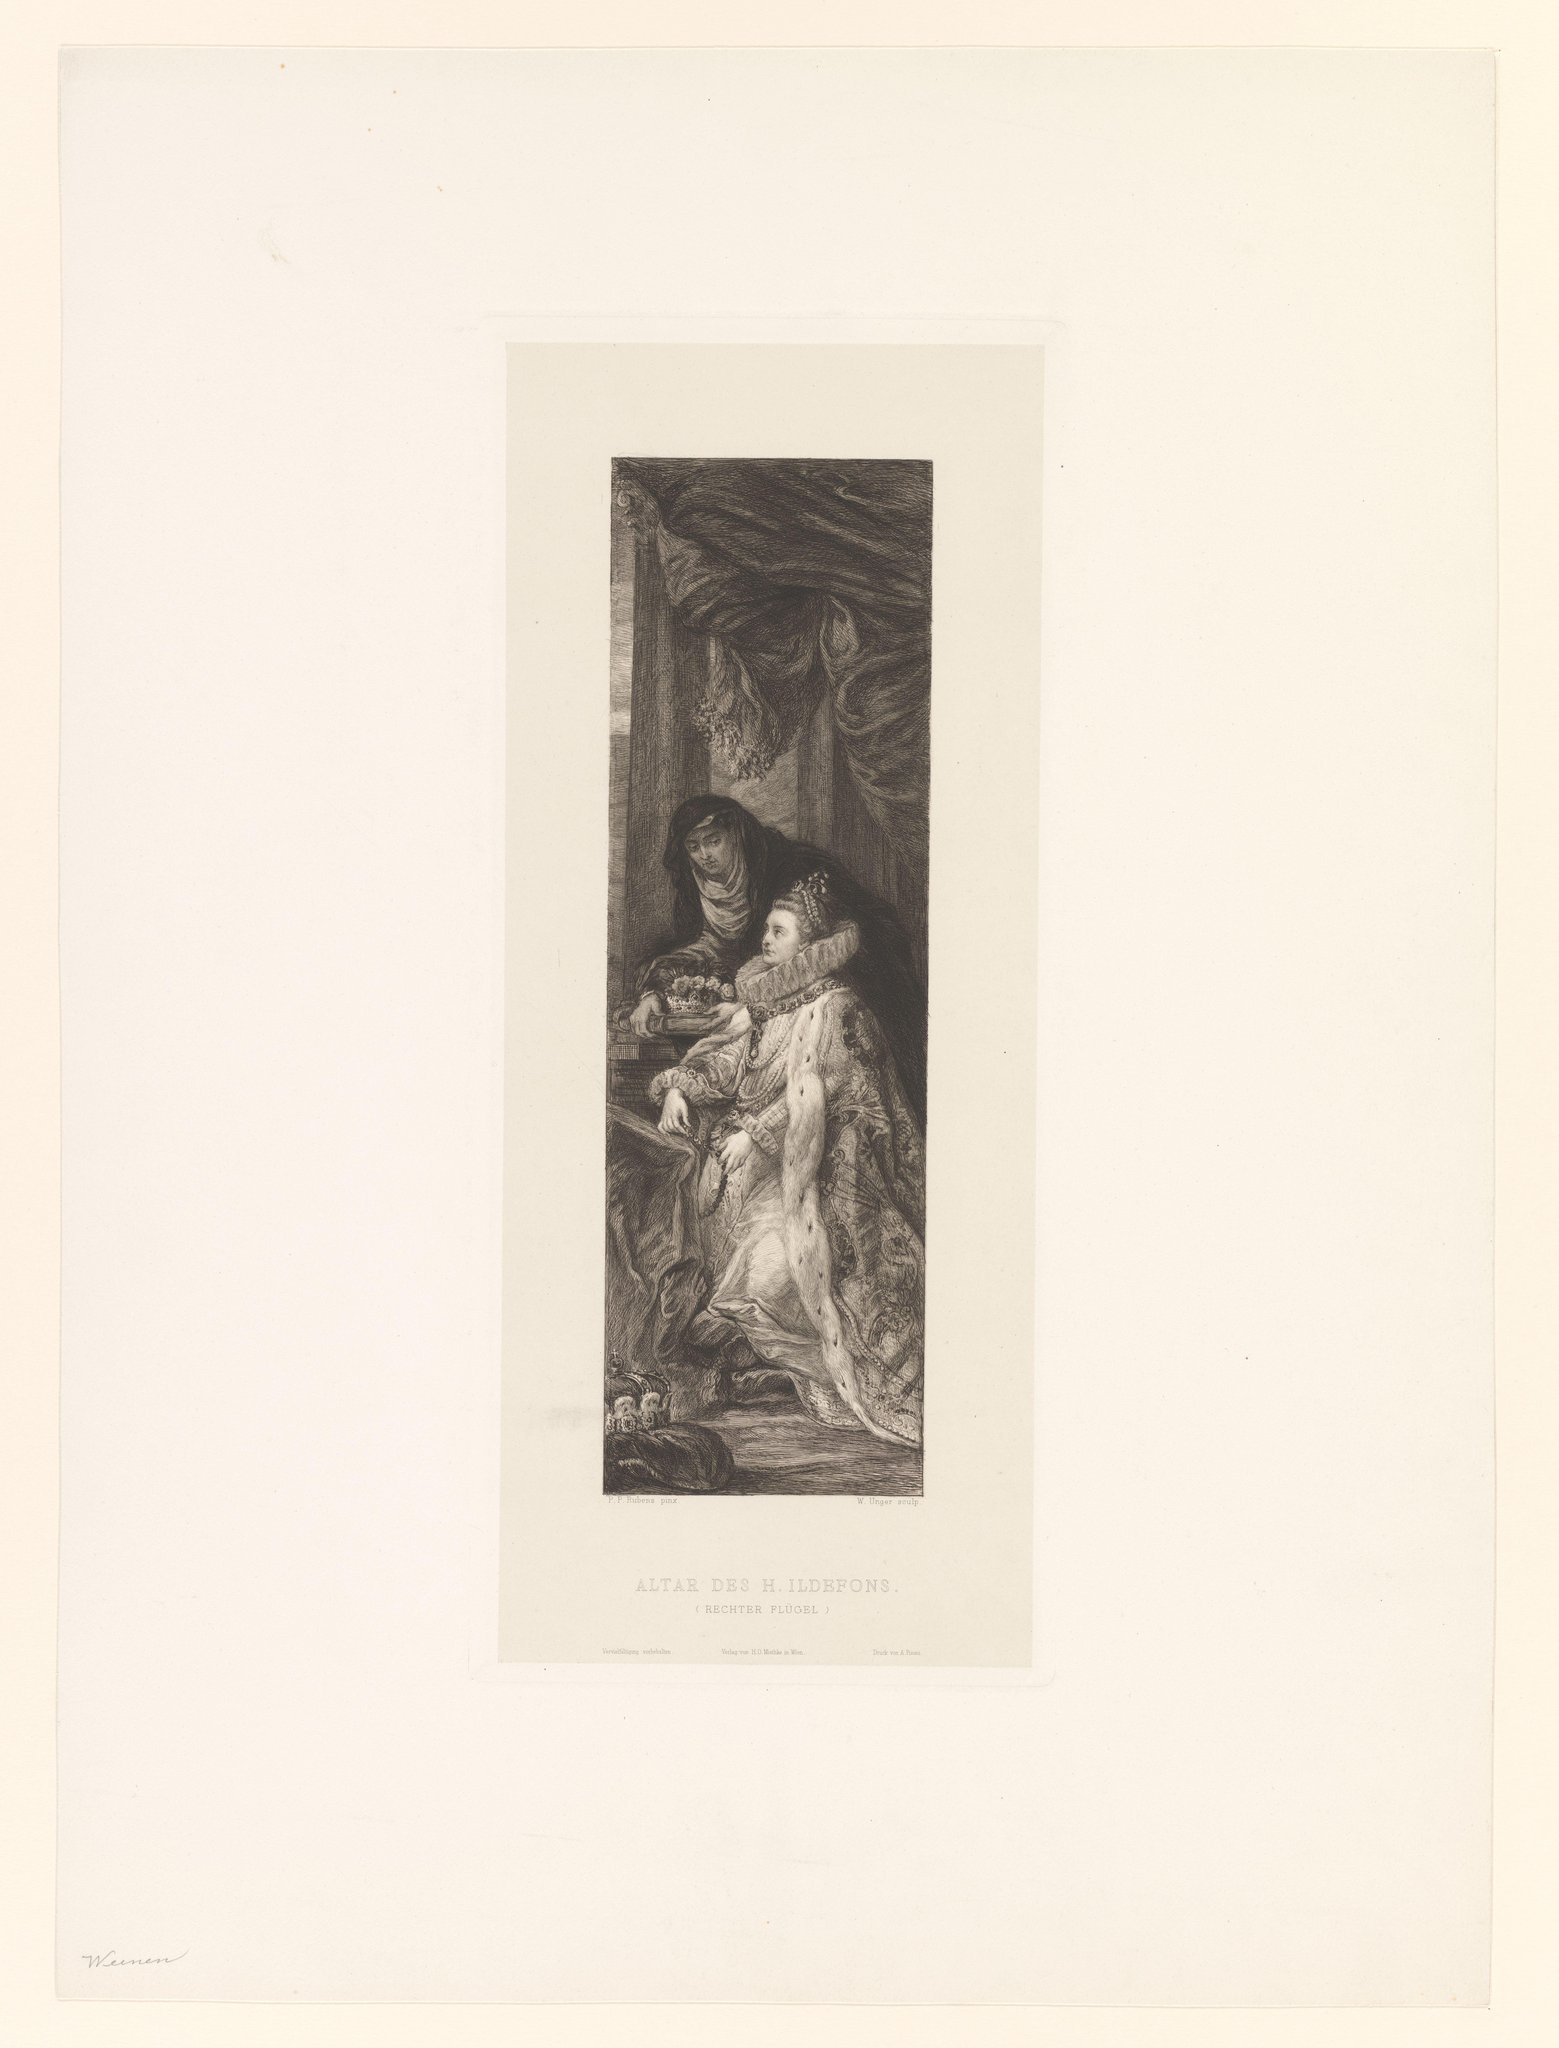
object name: print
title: Rechtervleugel van het altaar van Ildefonso: Isabella Clara Eugenia van Spanje met haar patroonheilige Elisabeth van Hongarije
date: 1861-1889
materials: paper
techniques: etching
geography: vienna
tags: infante van spanje isabella clara eugenia, the wife and widow of the landgrave of thuringia, and franciscan tertiary, elisabeth of hungary; possible attributes: beggar, cripple, fish, loaves, leper, model of church, pitcher, roses in lap, scald-head, three crowns, insignia and symbols of sovereignty (crown, diadem, sceptre, orb, seal, standard, cloak, pectoral)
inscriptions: collector's mark: Lugt 2228